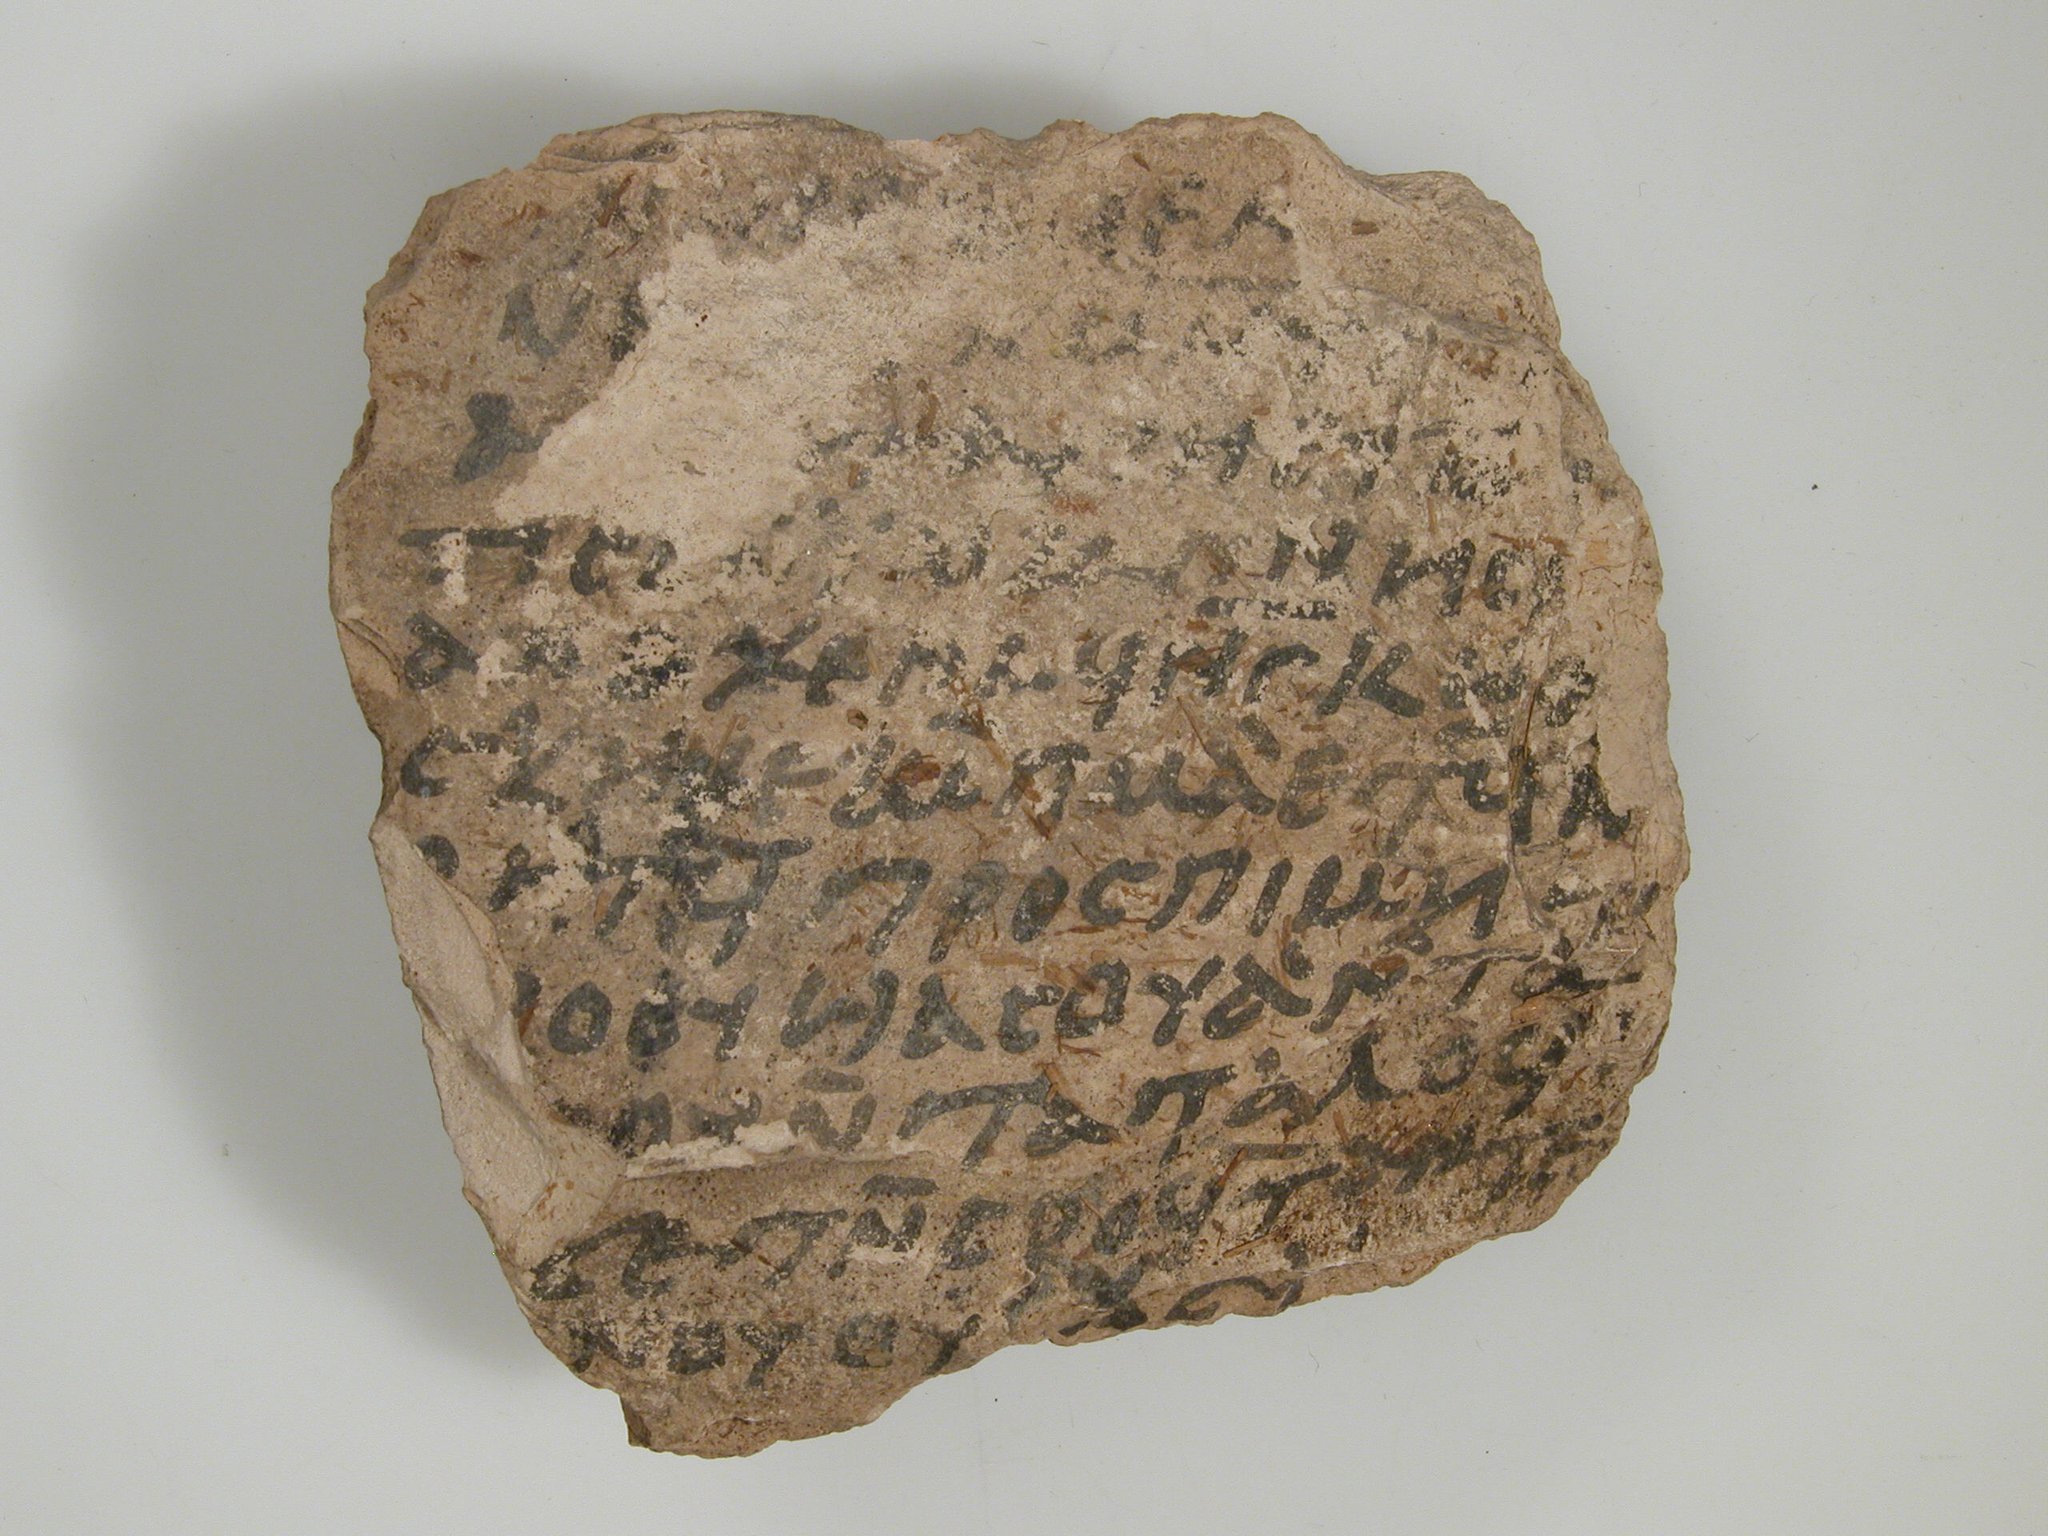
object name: ostrakon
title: Ostrakon with a Letter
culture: coptic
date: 580-640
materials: ink, limestone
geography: egypt